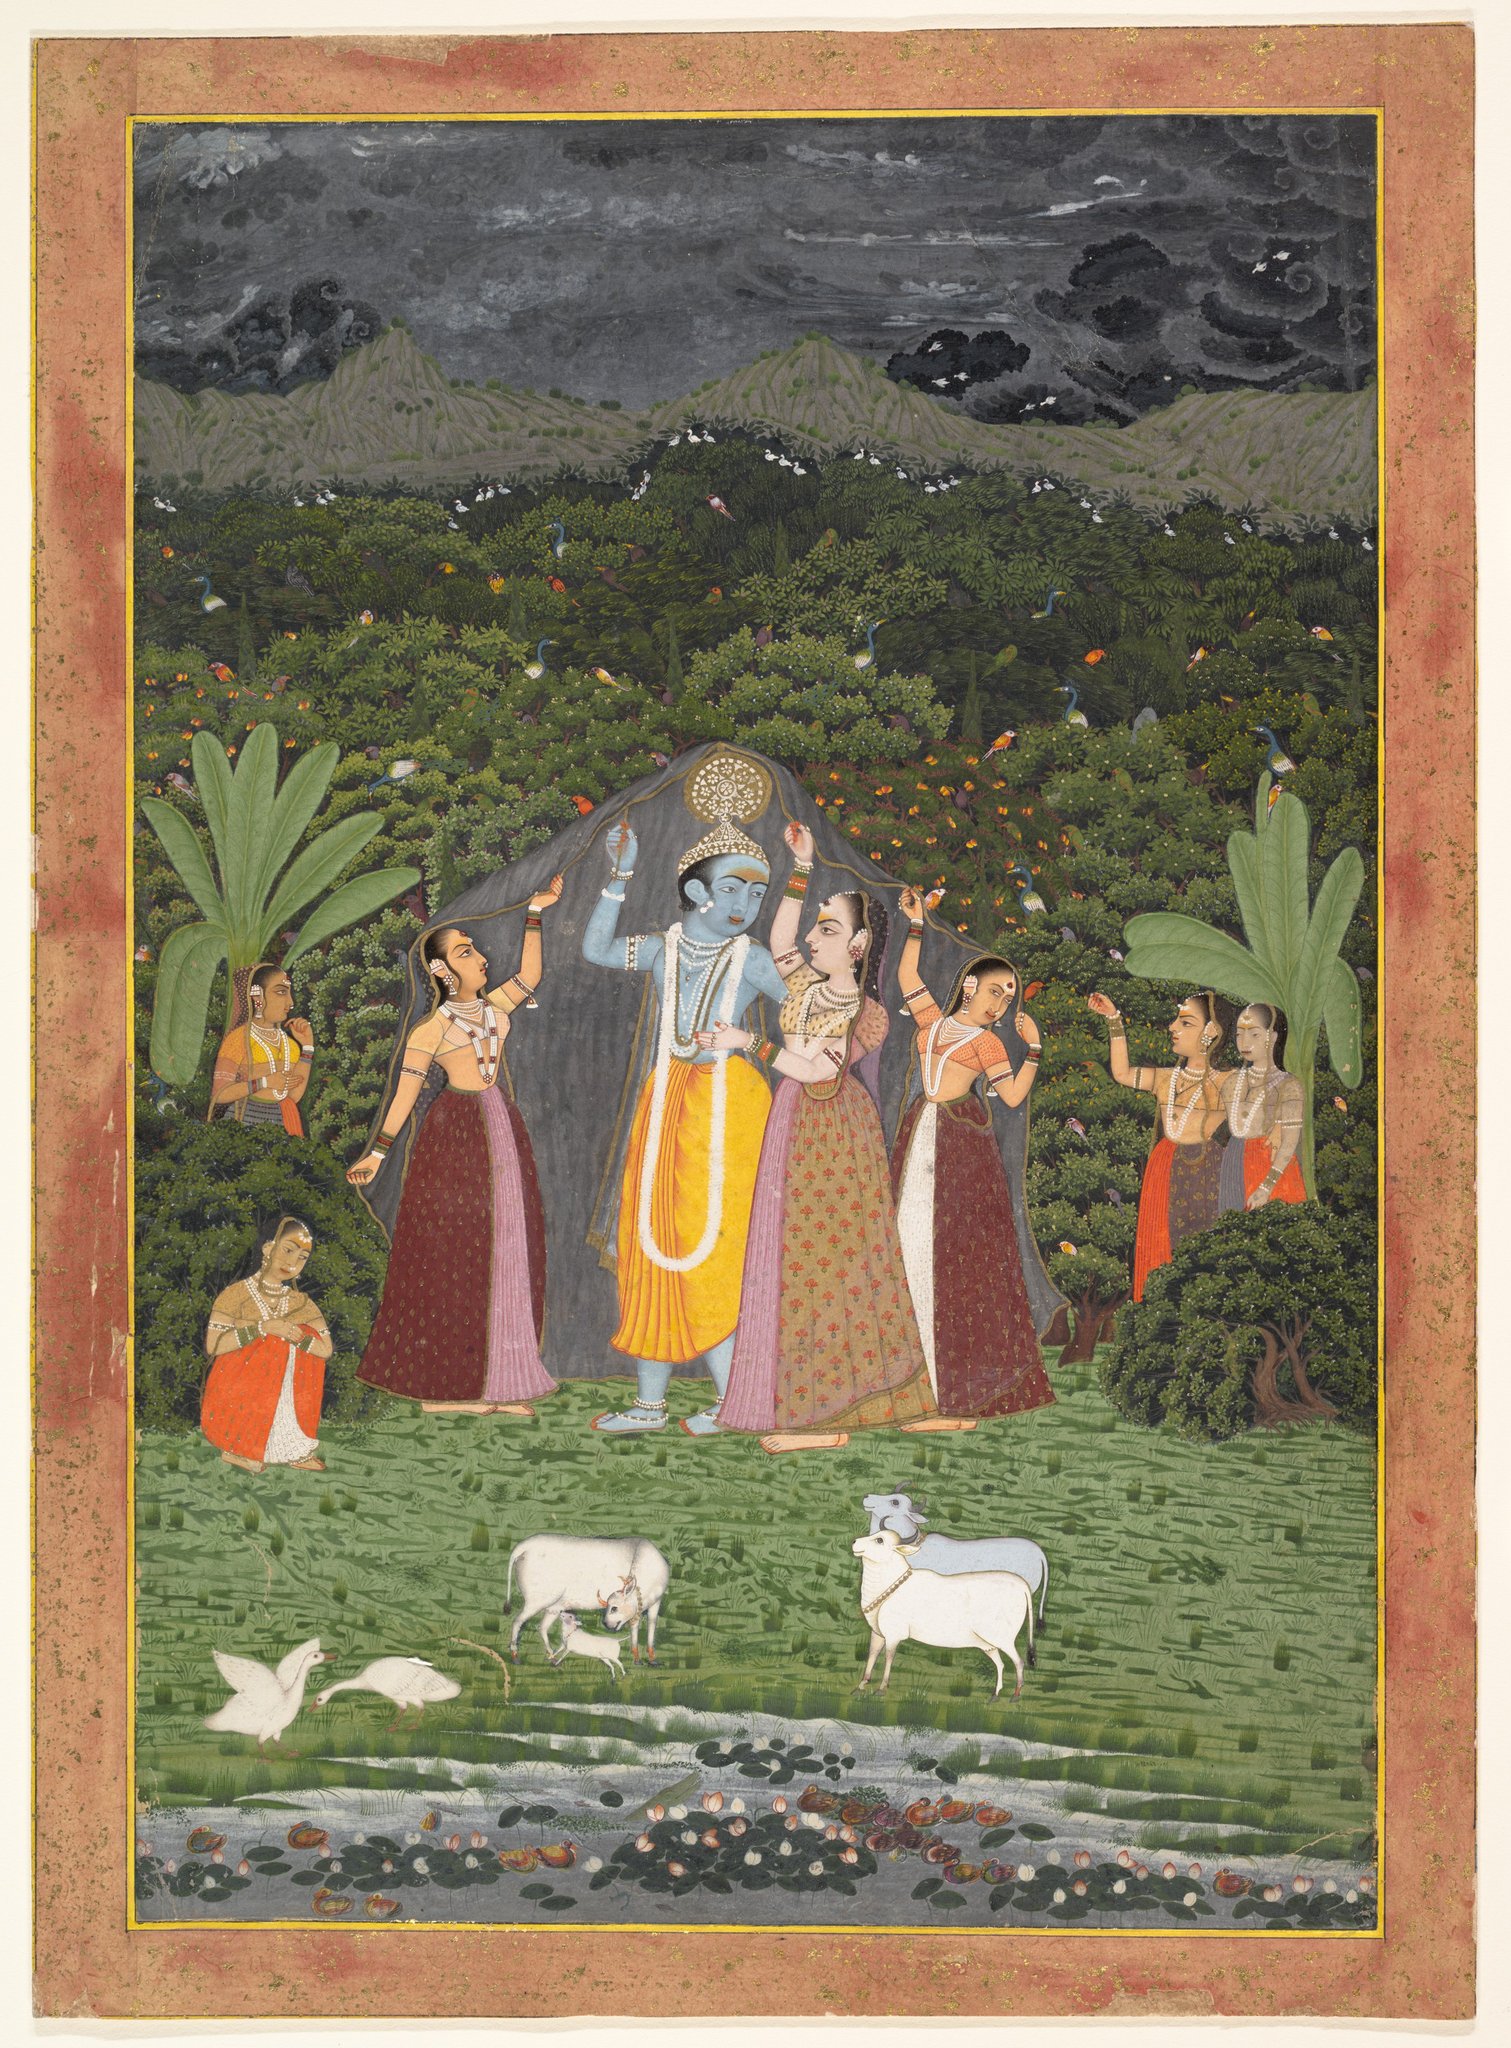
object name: painting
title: Krishna and the Gopis Take Shelter from the Rain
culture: indian, rajasthani, jaipur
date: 1760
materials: gold, ink, paper, watercolor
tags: birds,women,cows,krishna,hinduism